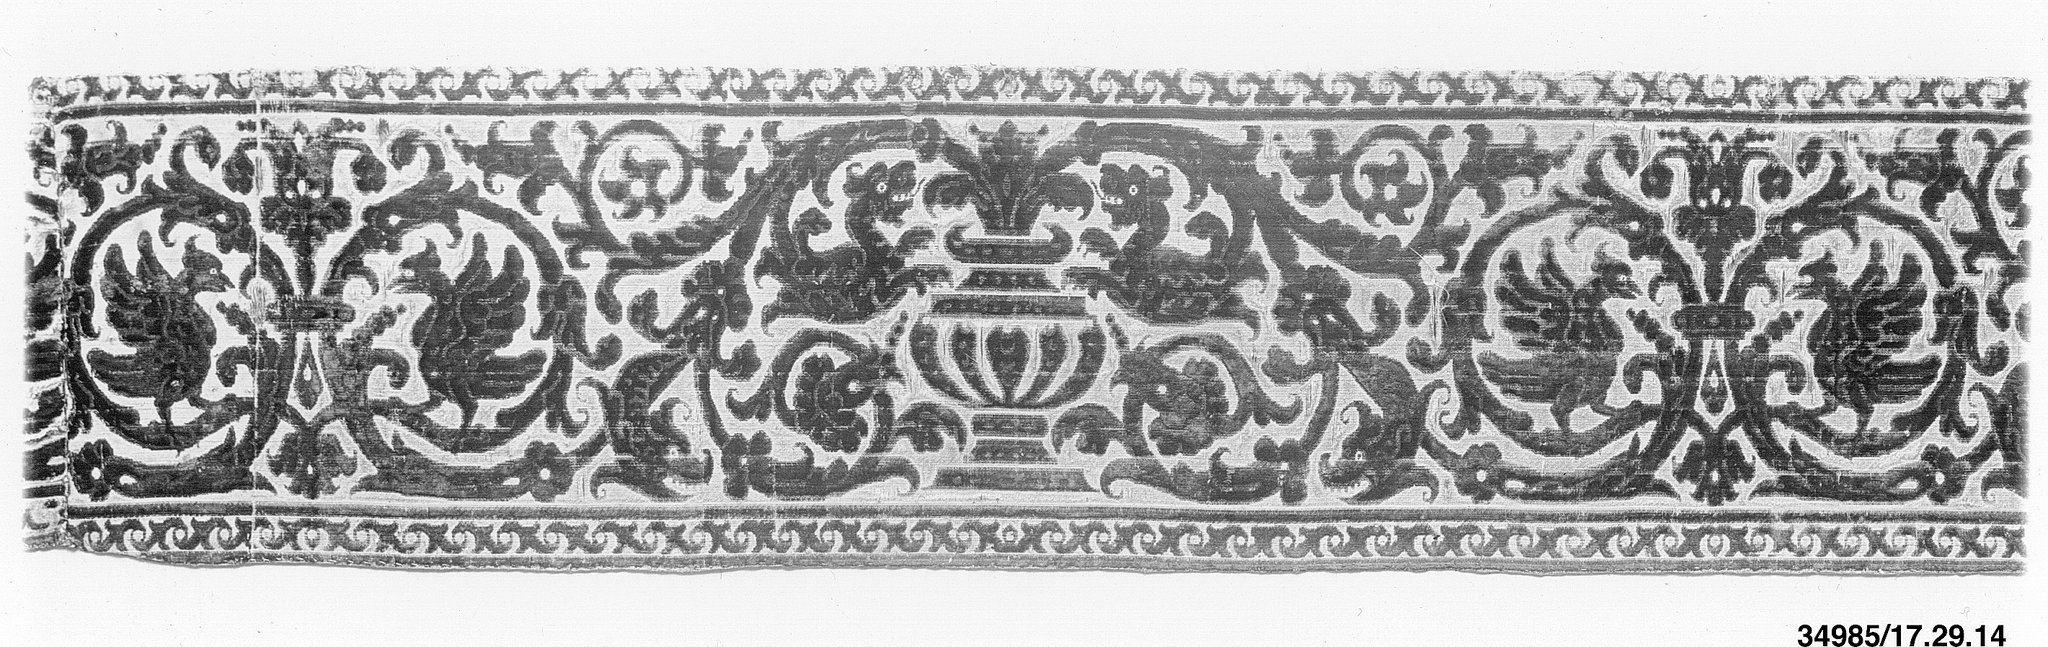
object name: border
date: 1601-1700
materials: silk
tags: birds,dragons